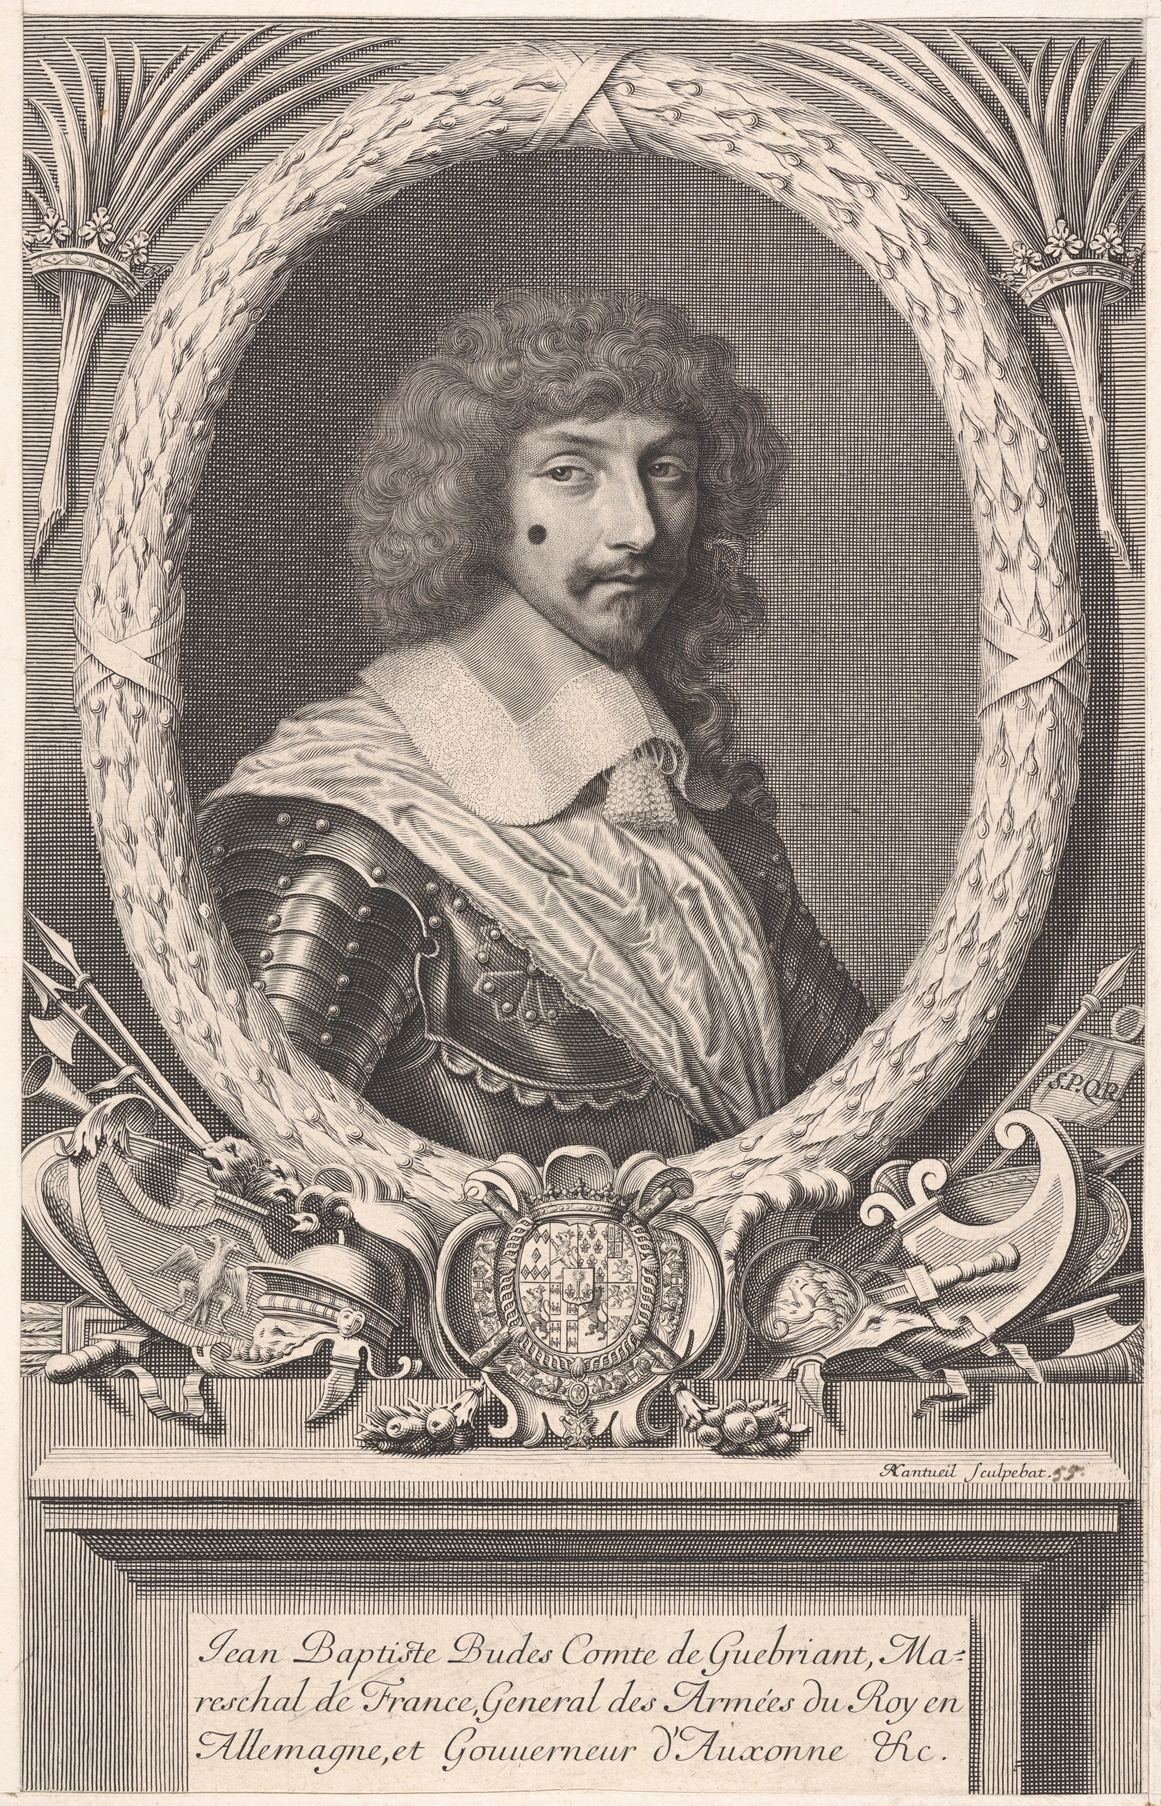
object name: print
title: Jules-Paul de Lionne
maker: robert nanteuil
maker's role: artist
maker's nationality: french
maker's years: 1623-1678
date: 1667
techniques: engraving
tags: men,portraits,coat of arms